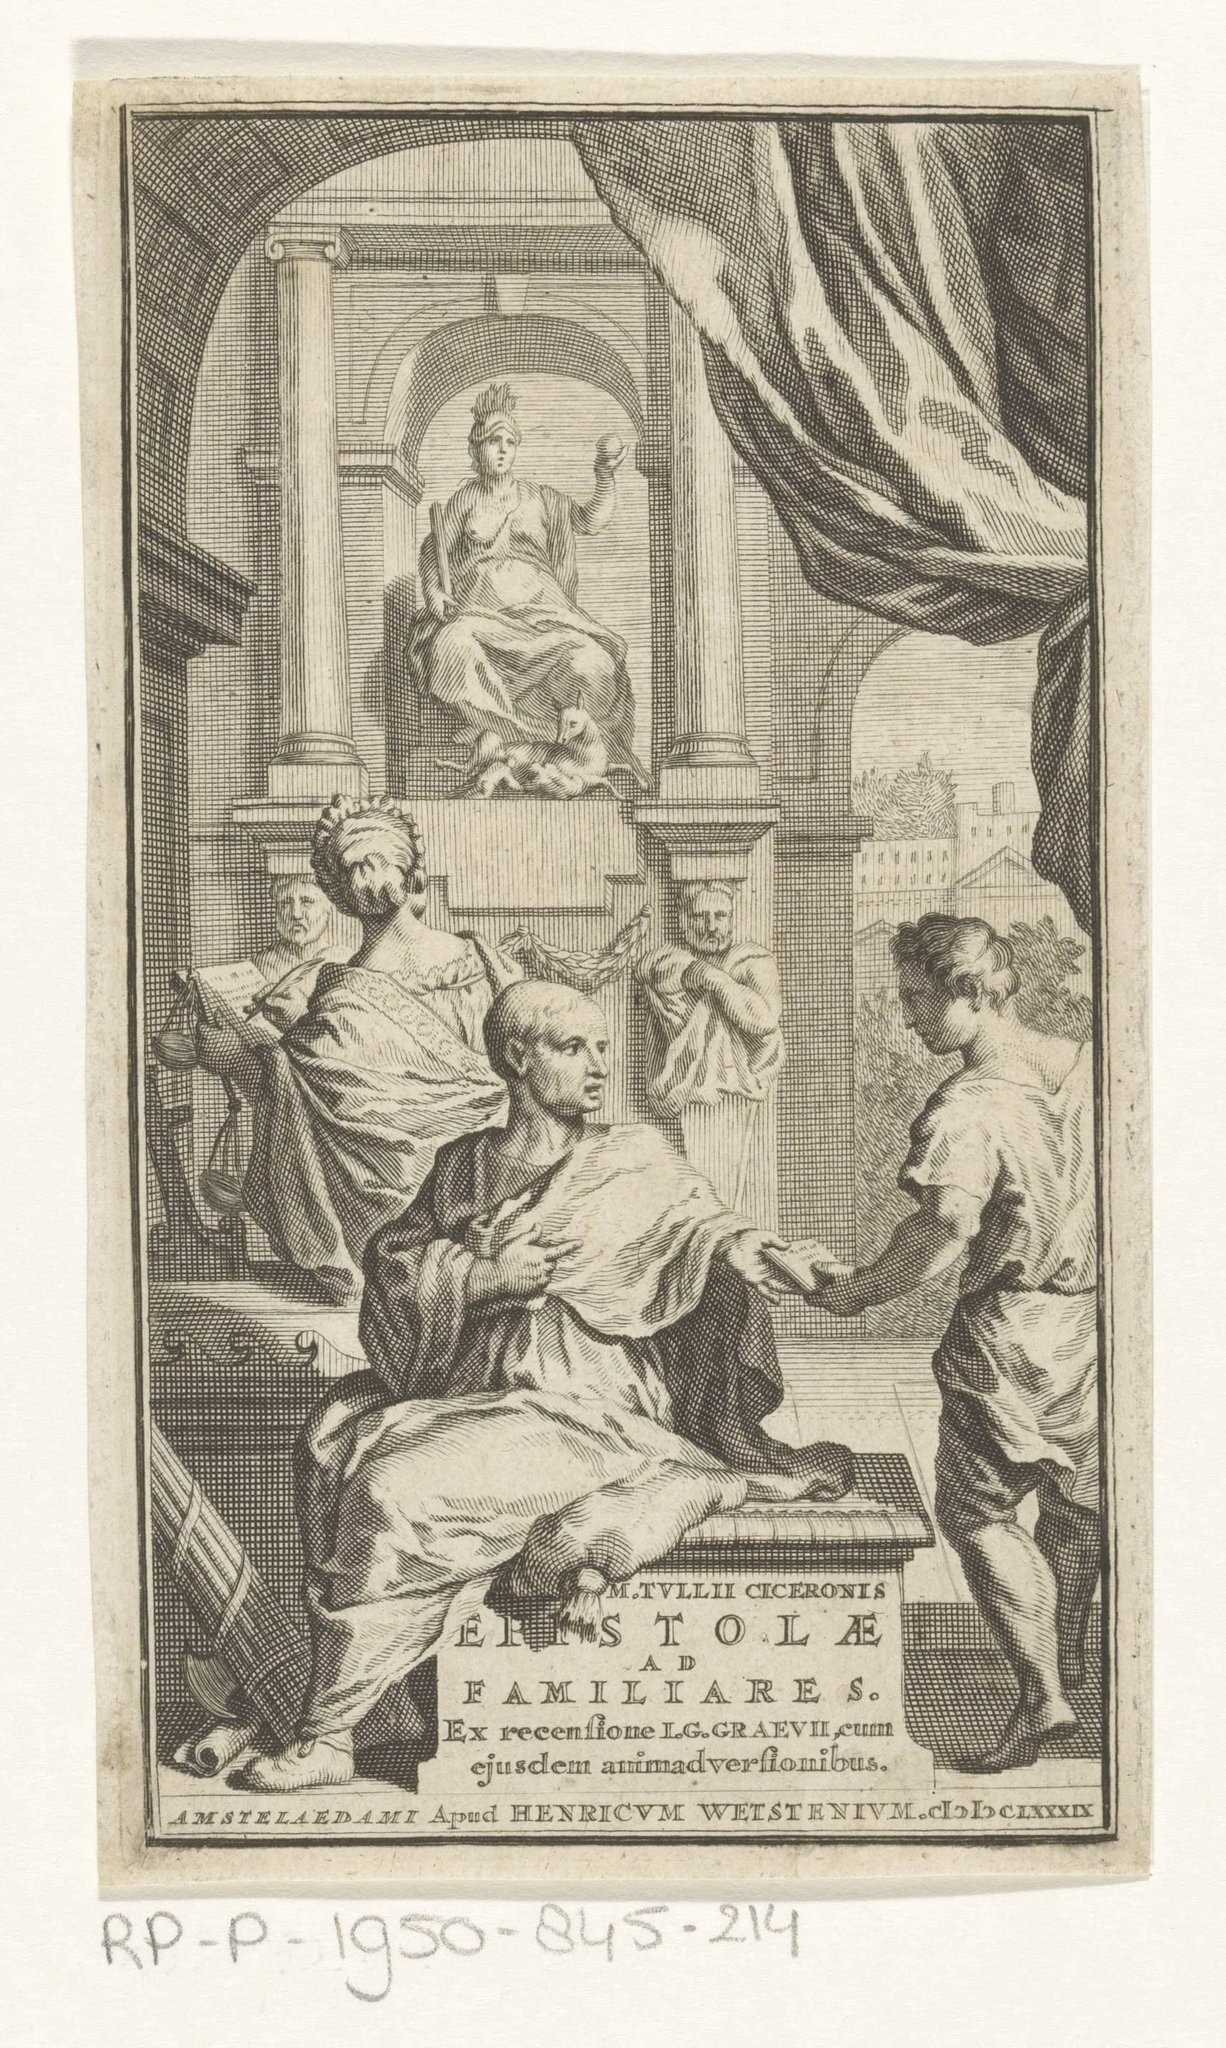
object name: titelblad, titelpagina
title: Titelpagina voor: Cicero en Johannes Georgius Graevius, Epistolae ad familiares, 1689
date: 1689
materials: paper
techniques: engraving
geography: amsterdam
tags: marcus tullius cicero, (story of) cicero, writing and letters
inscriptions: collector's mark: Lugt 2228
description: Titelpagina voor: Cicero en Graevius, Johannes Georgius. Epistolae ad familiares. Amsterdam: Wetstein, Henricus, 1689. Prent afkomstig uit een plakalbum met titelprenten, ornamenten etc. op blauw papier in 1983 uit elkaar gehaald. Volgens een notitie op verso zat de prent op p. 214 van dit album.